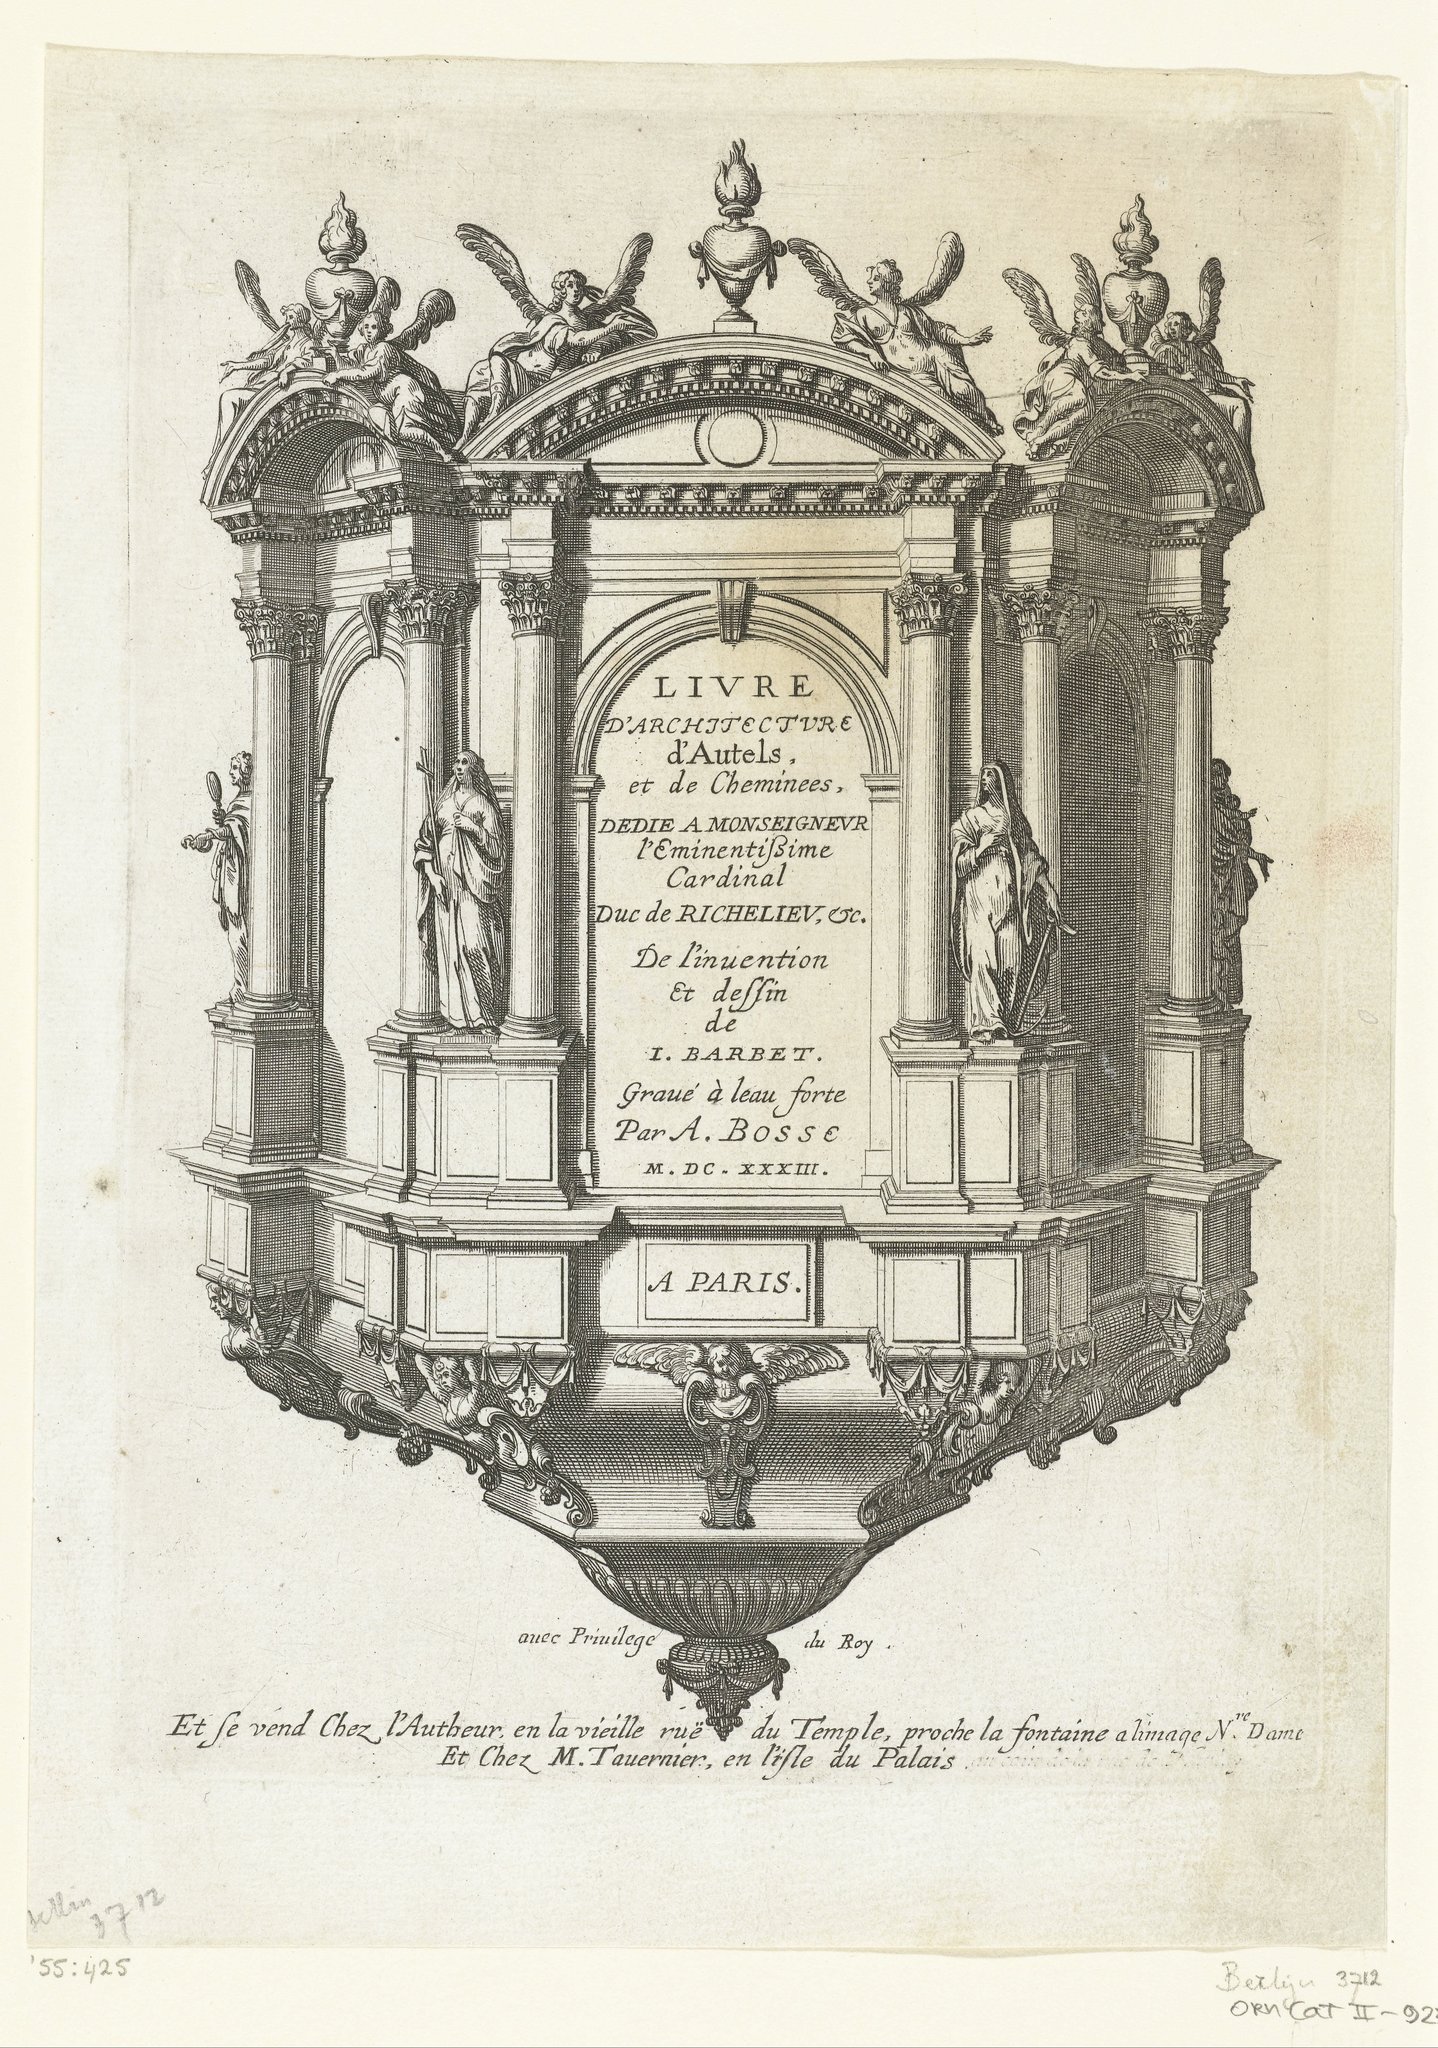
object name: print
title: Livre d' Architecture et d' Autels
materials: paper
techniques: etching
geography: paris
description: De tekst staat in het midden van een orgelkast. Titelblad uit tweede uitgave van serie. De nummering van de prenten komt slechts gedeeltelijk overeen met die van de eerste editie.